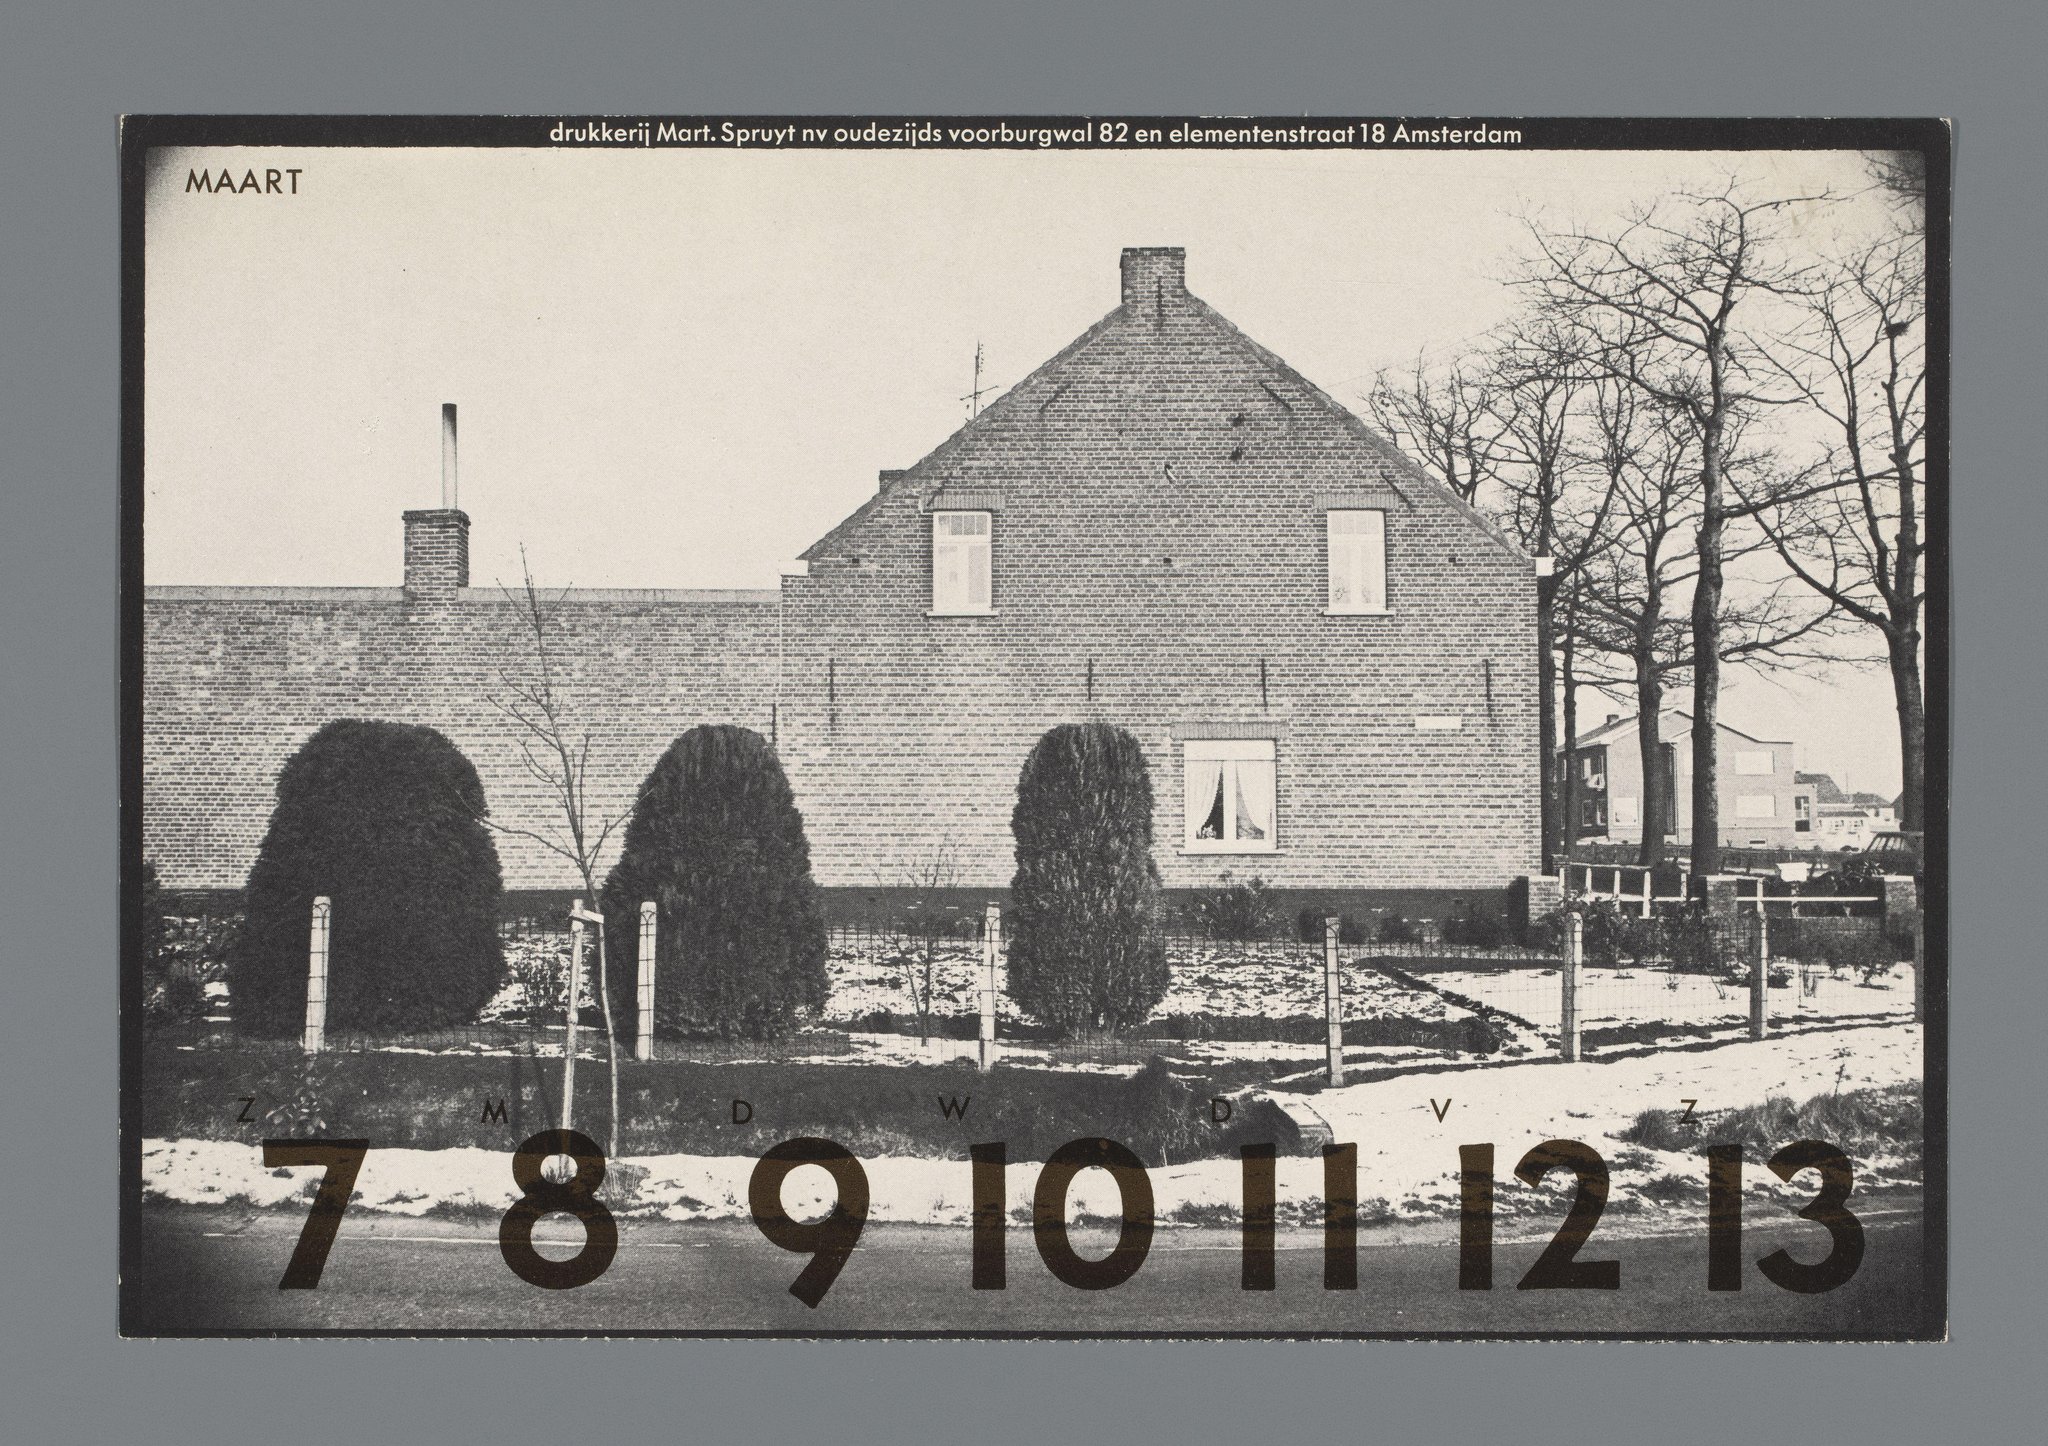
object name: photograph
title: België. Huizen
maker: Anonymous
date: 1900-1950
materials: paper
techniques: offset printed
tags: belgium